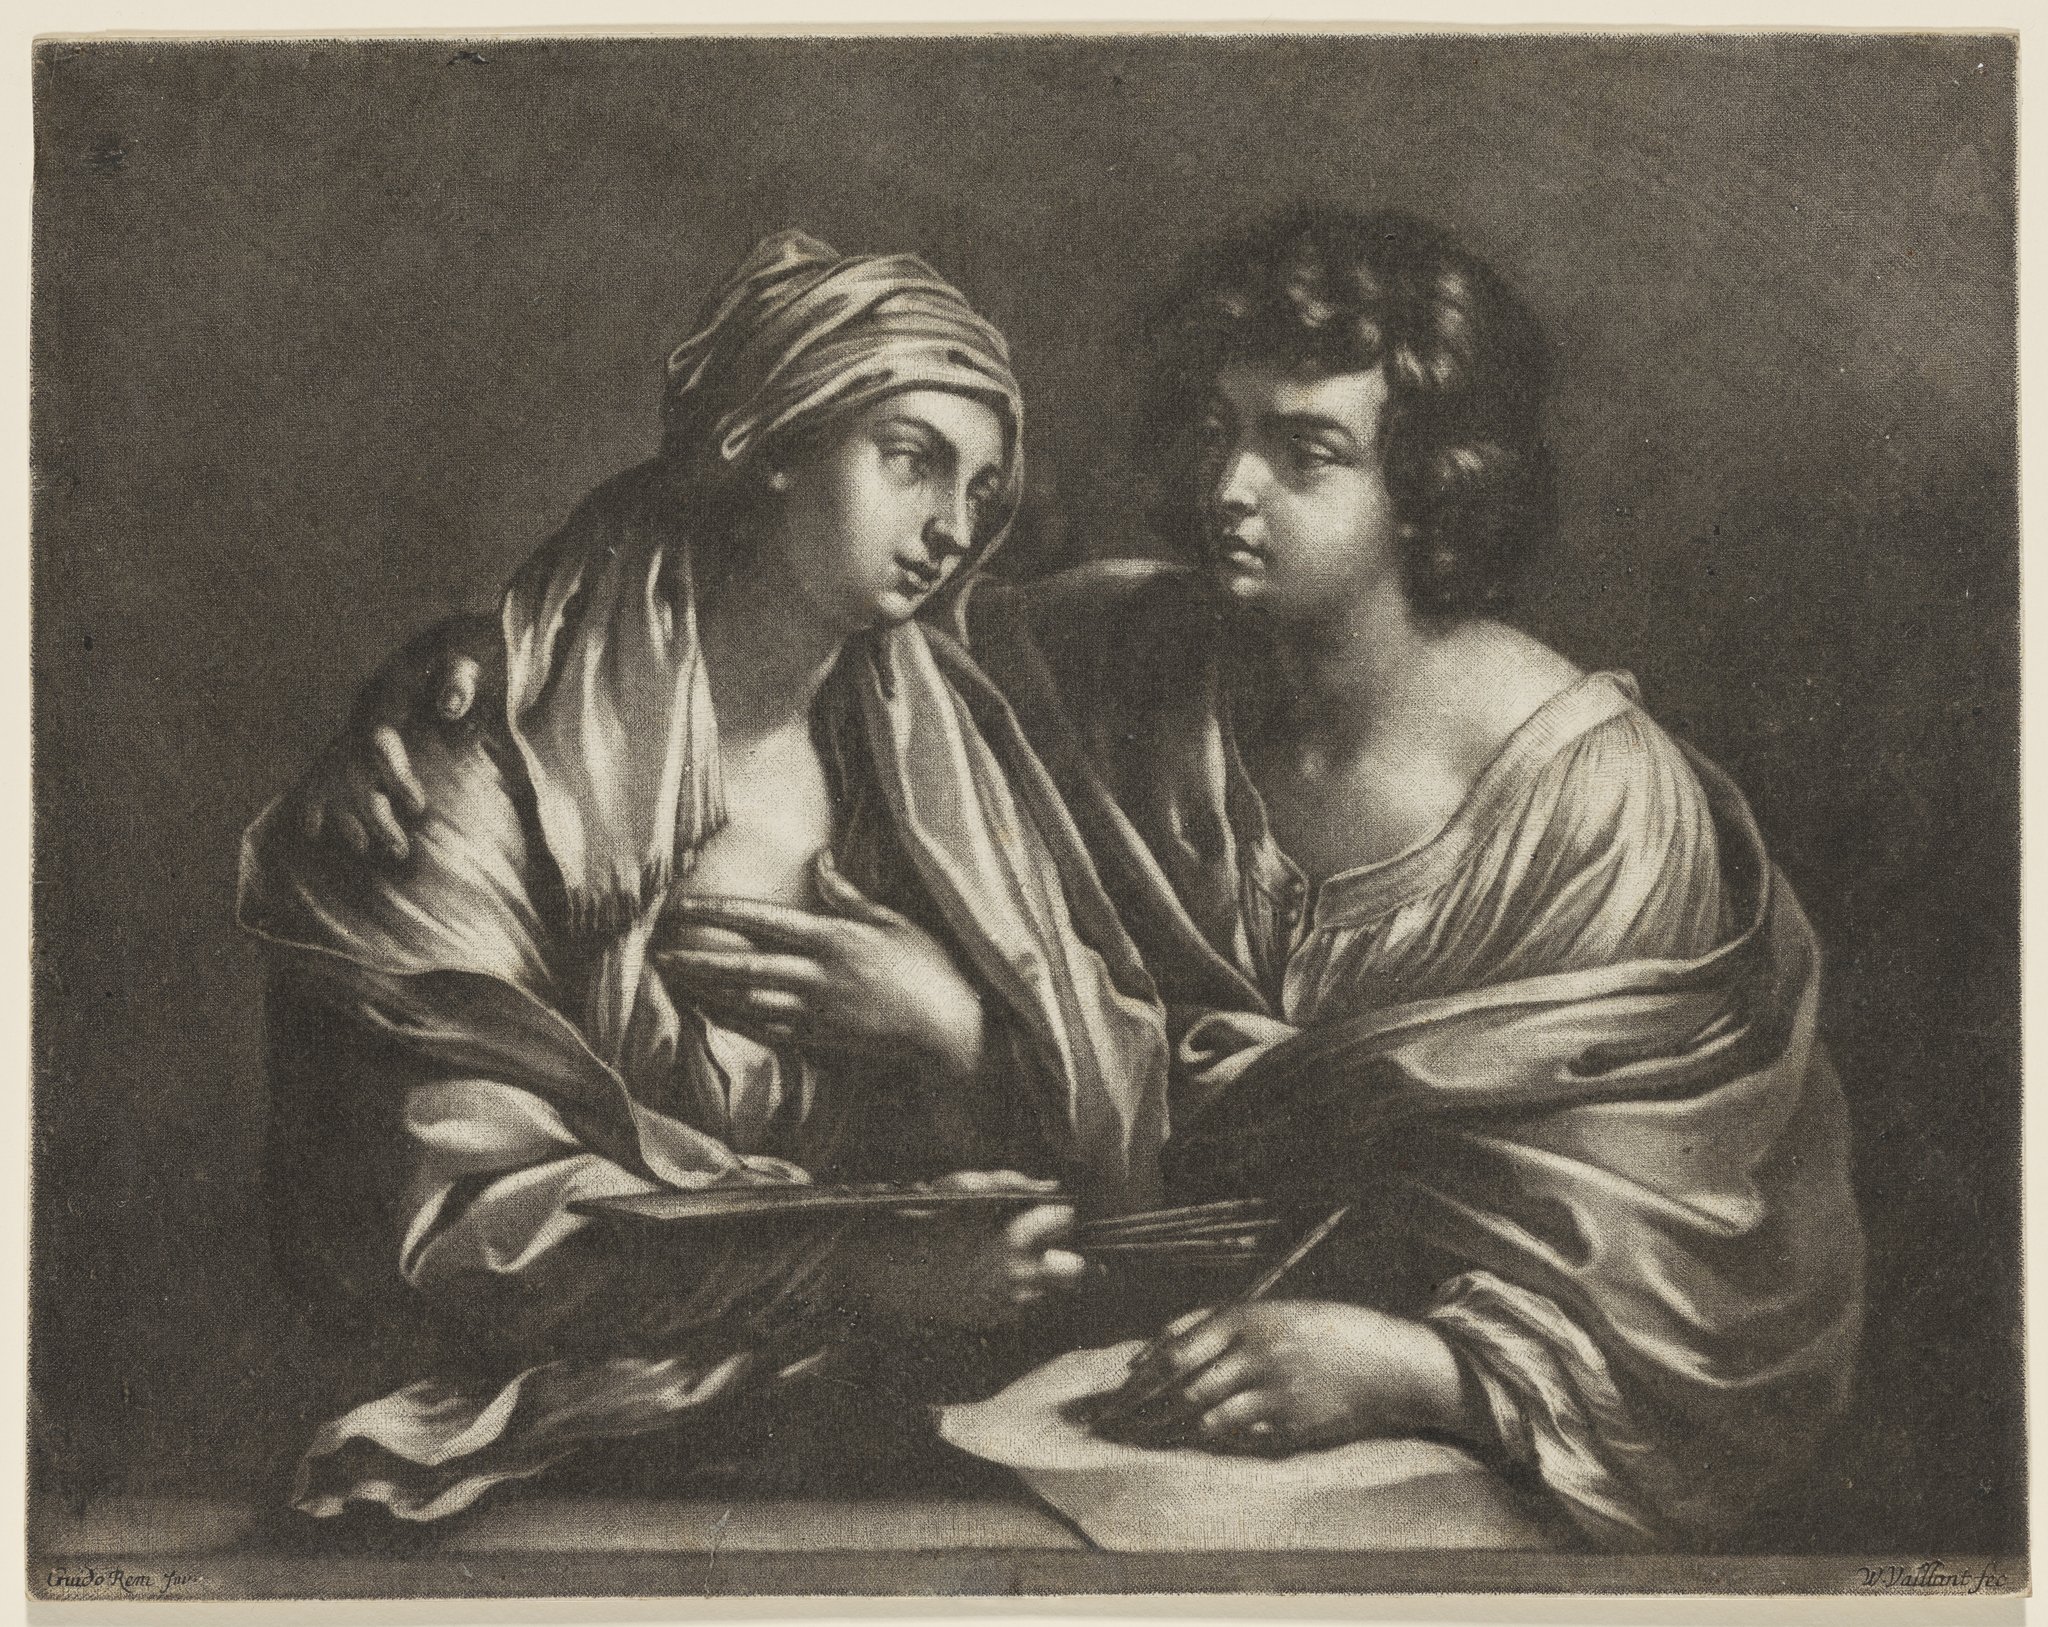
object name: print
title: Personification of Painting and Drawing (or a draughtsman and Pictura)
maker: wallerant vaillant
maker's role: artist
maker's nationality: dutch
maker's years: 1623-1677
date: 1640-1677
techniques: mezzotint